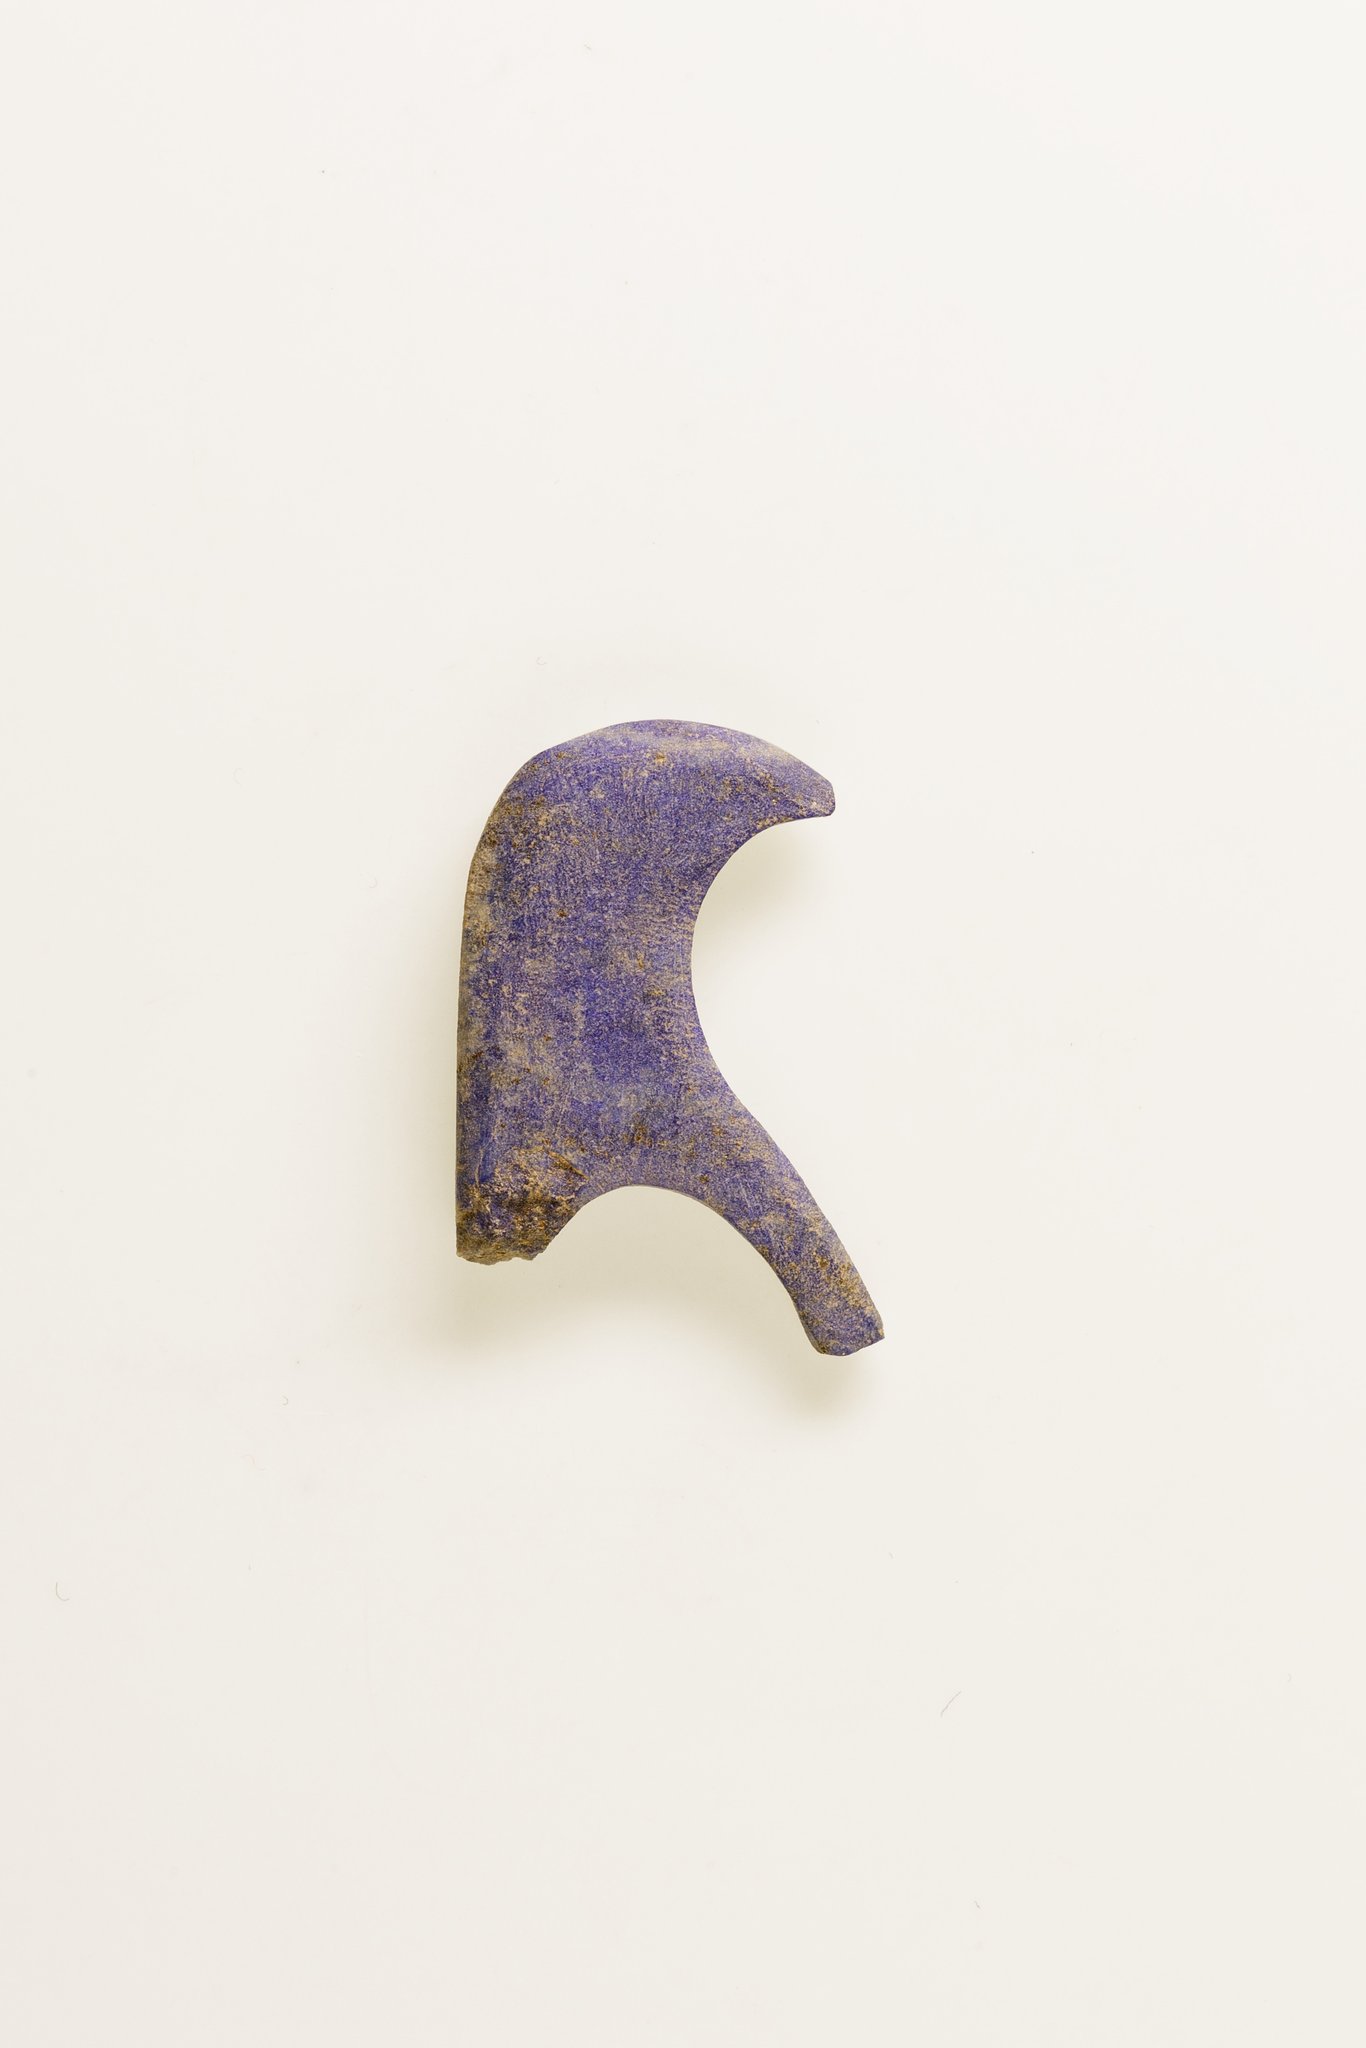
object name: inlay, wig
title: Fragment of wing inlay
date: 522-343 BCE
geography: egypt